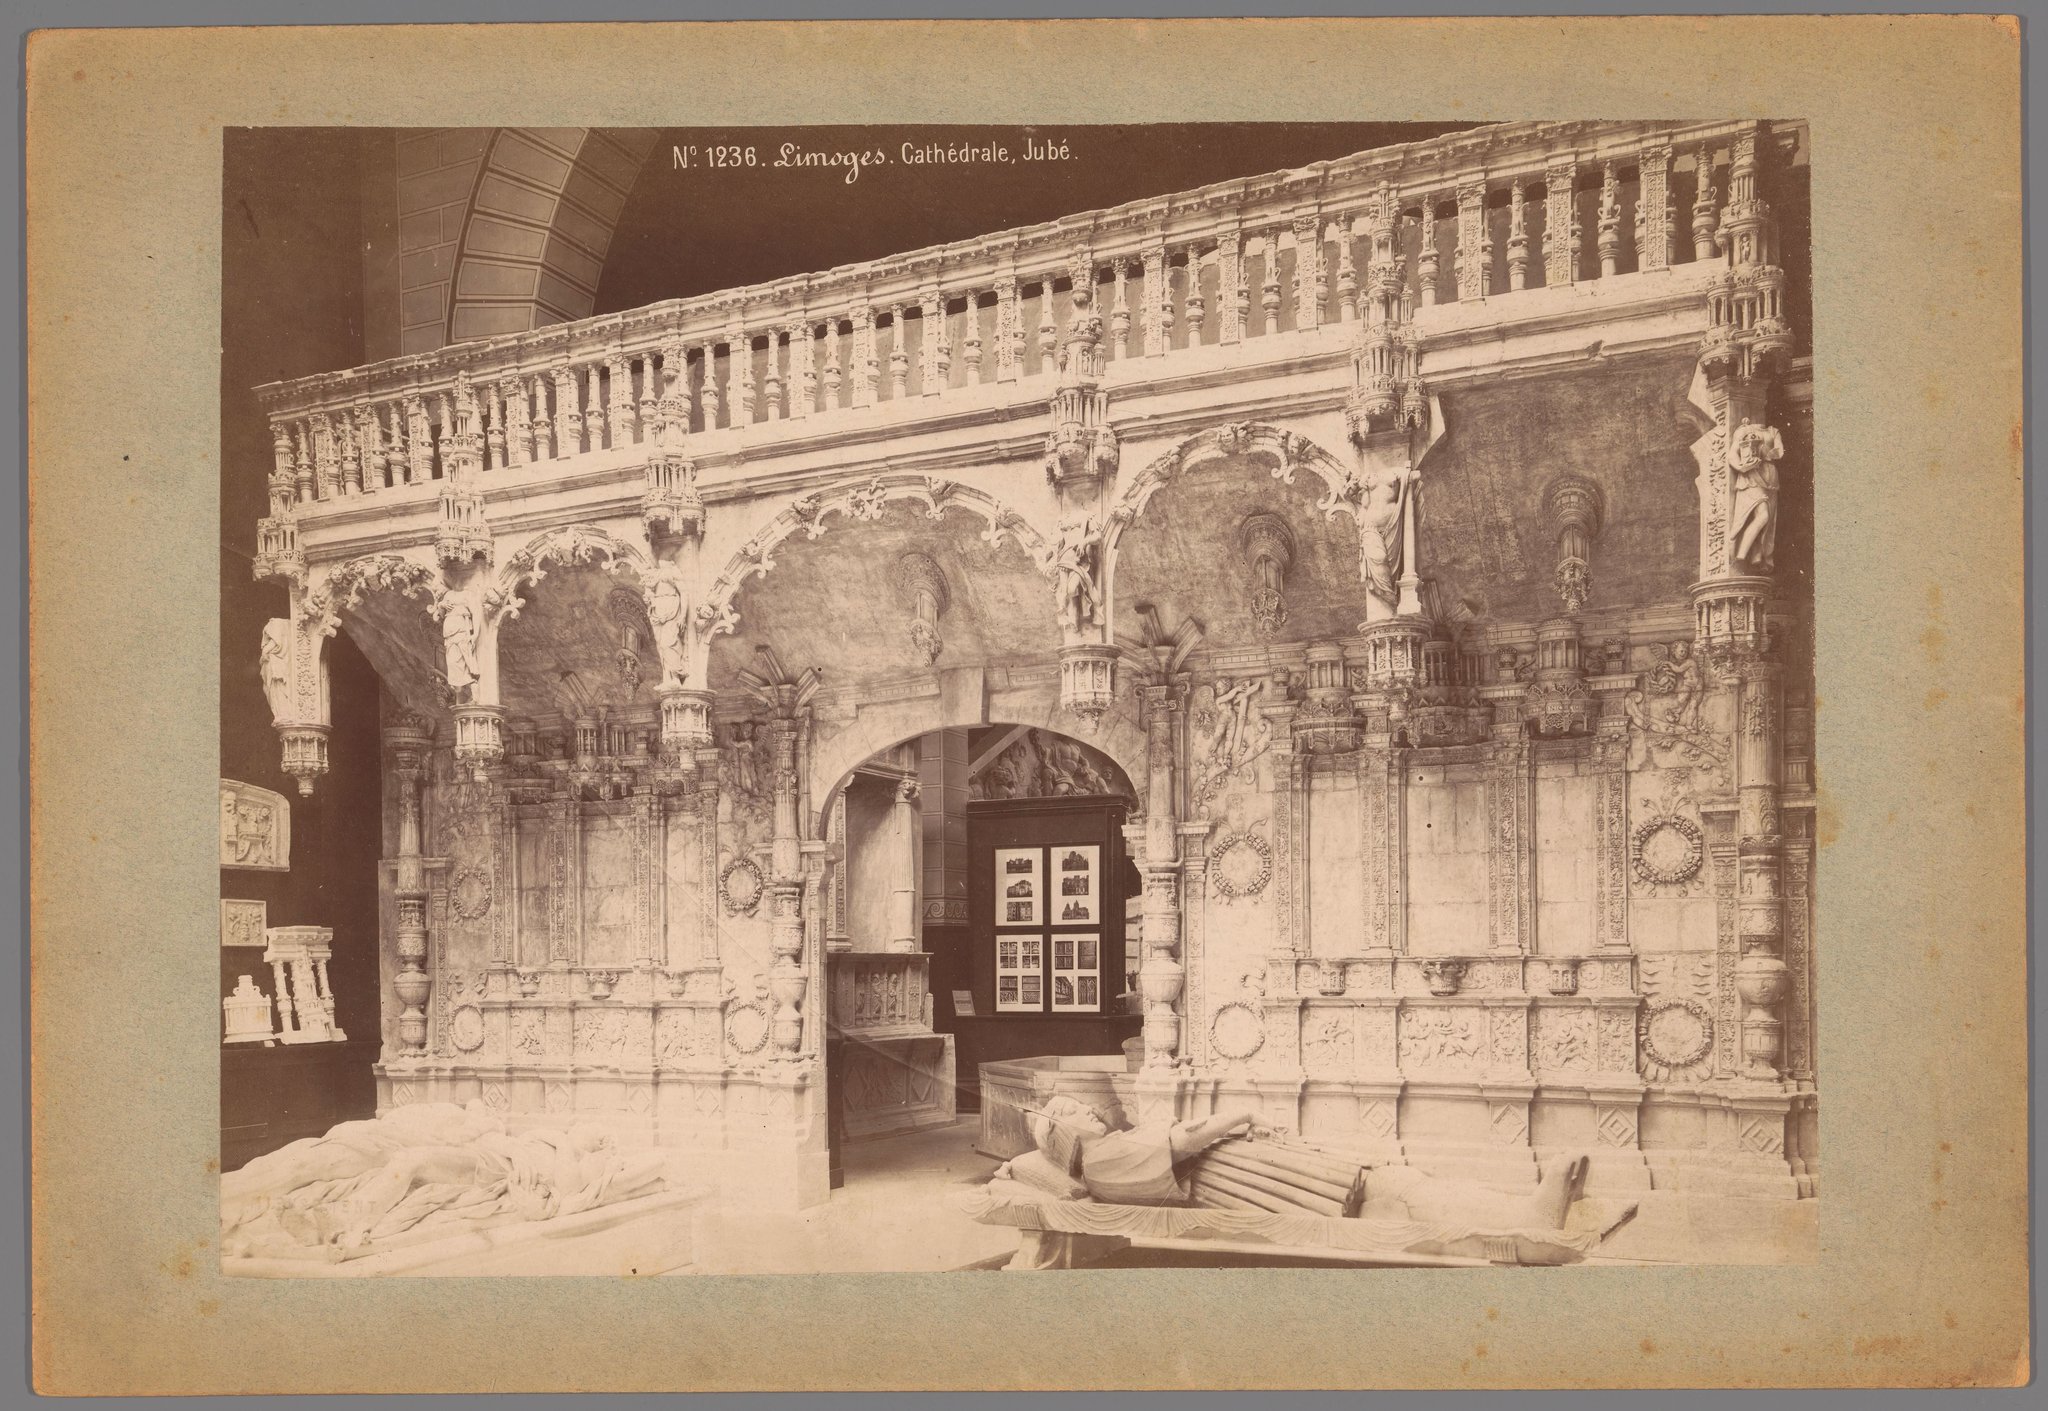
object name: photograph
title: Opstelling van een gipsafgietsel van het oksaal uit de Kathedraal van Limoges in het Musée des Monuments français te Parijs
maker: séraphin-médéric mieusement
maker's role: fotograaf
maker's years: 1840-1905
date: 1875-1900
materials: cardboard, photographic support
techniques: albumen print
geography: palais du trocadéro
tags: rood-screen, choir-screen; iconostasis, art (+ plaster ~ arts), grave, tomb, permanent exhibition, museum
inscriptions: name: ‘KUNSTBOEKHANDEL J. A. G. DE LEUR PHOTOGRAAF - UITGEVER HUIGENSPARK, 40b. DEN HAAG.’, inscription: ‘MONUMENTS HISTORIQUES’, number: ‘No. 1236.’, name: ‘MIEUSEMENT PHOTOGRAPHE’, collector's mark: Lugt 3937